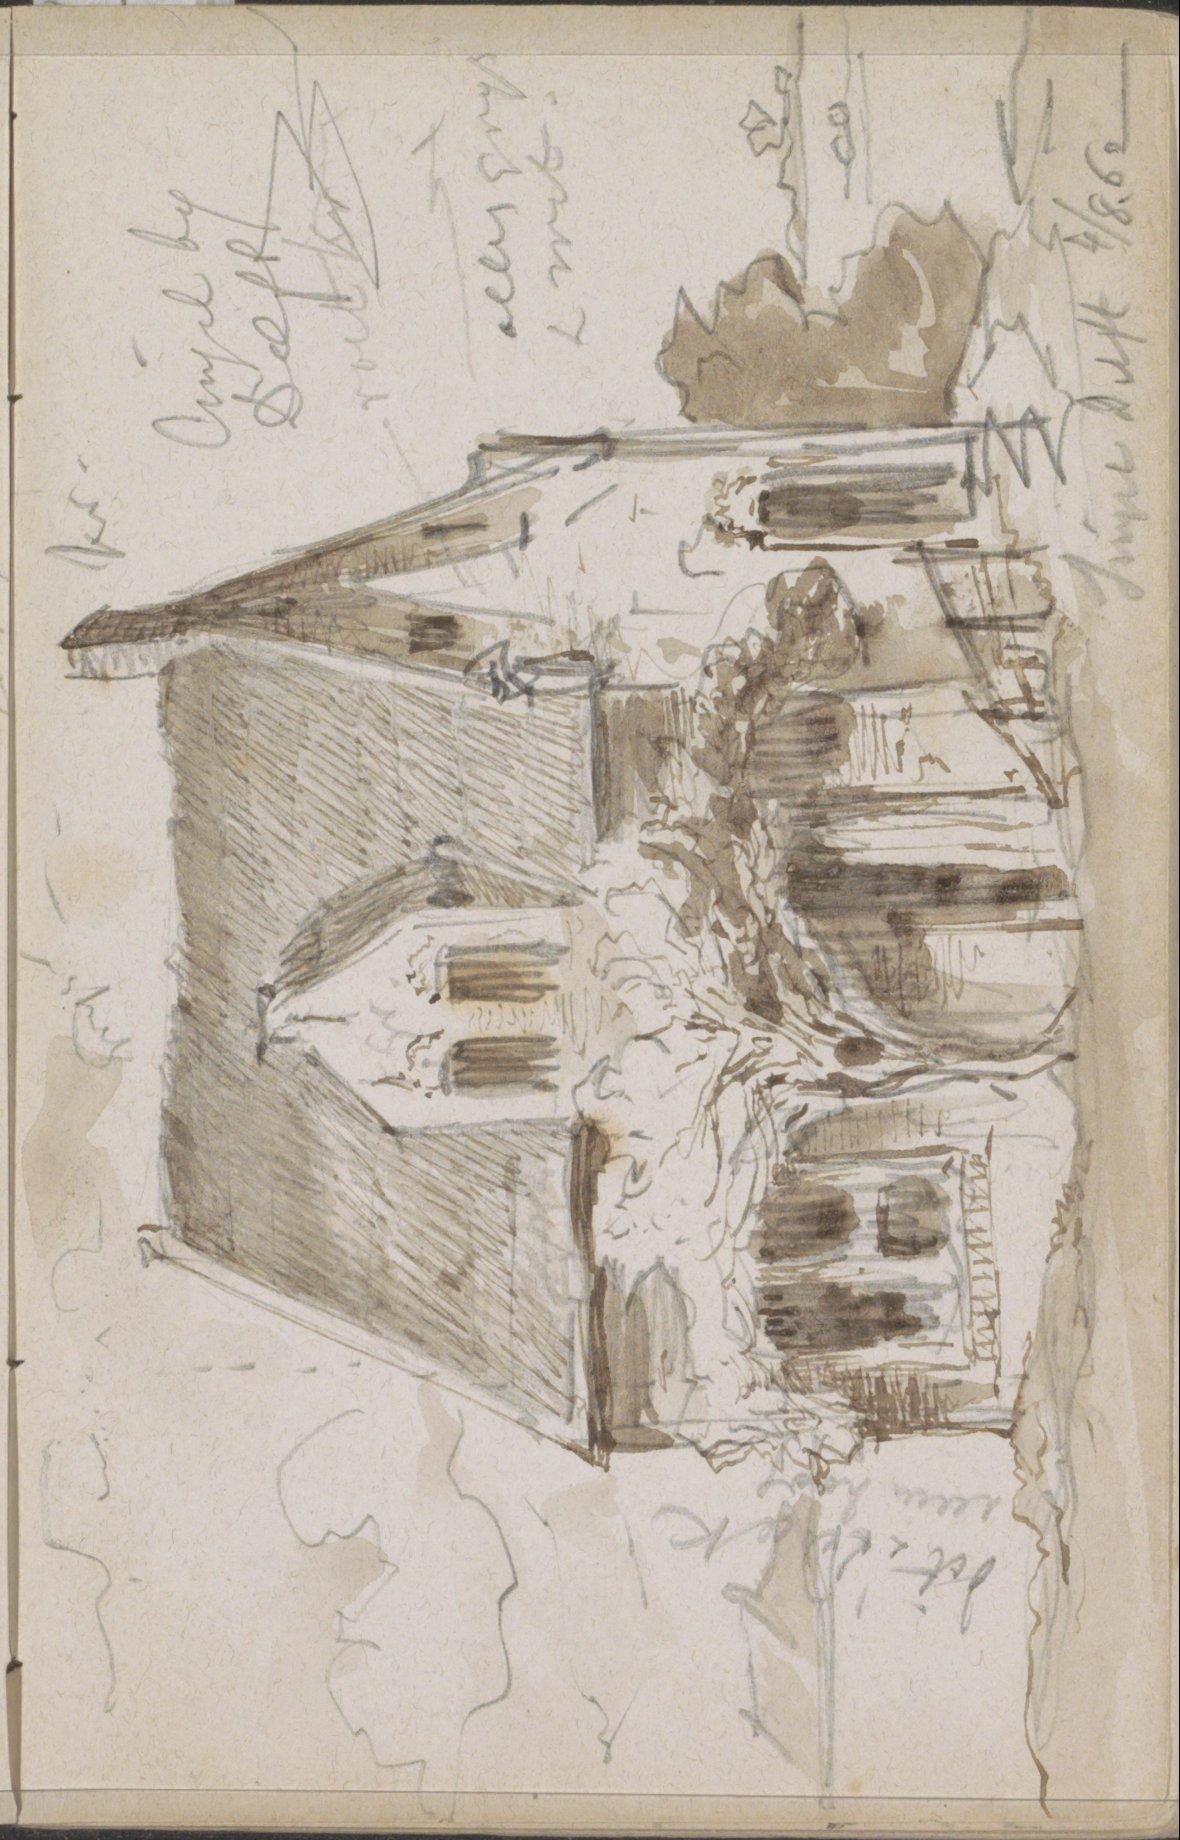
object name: sketchbook leaf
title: Huis aan de Singel bij Delft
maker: johannes tavenraat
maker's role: draughtsman, painter, print maker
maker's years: 1809-1881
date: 1808-1862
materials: ink, paper, pencil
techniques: brush, pen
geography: delft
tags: city-view, and landscape with man-made constructions, landscapes with waters, waterscapes, seascapes (in the temperate zone), housing, delft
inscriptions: date and inscription: ‘Cingel bij/ Delft/ si[...] 4/8 62’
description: Blad 26 recto uit een schetsboek met 65 bladen.